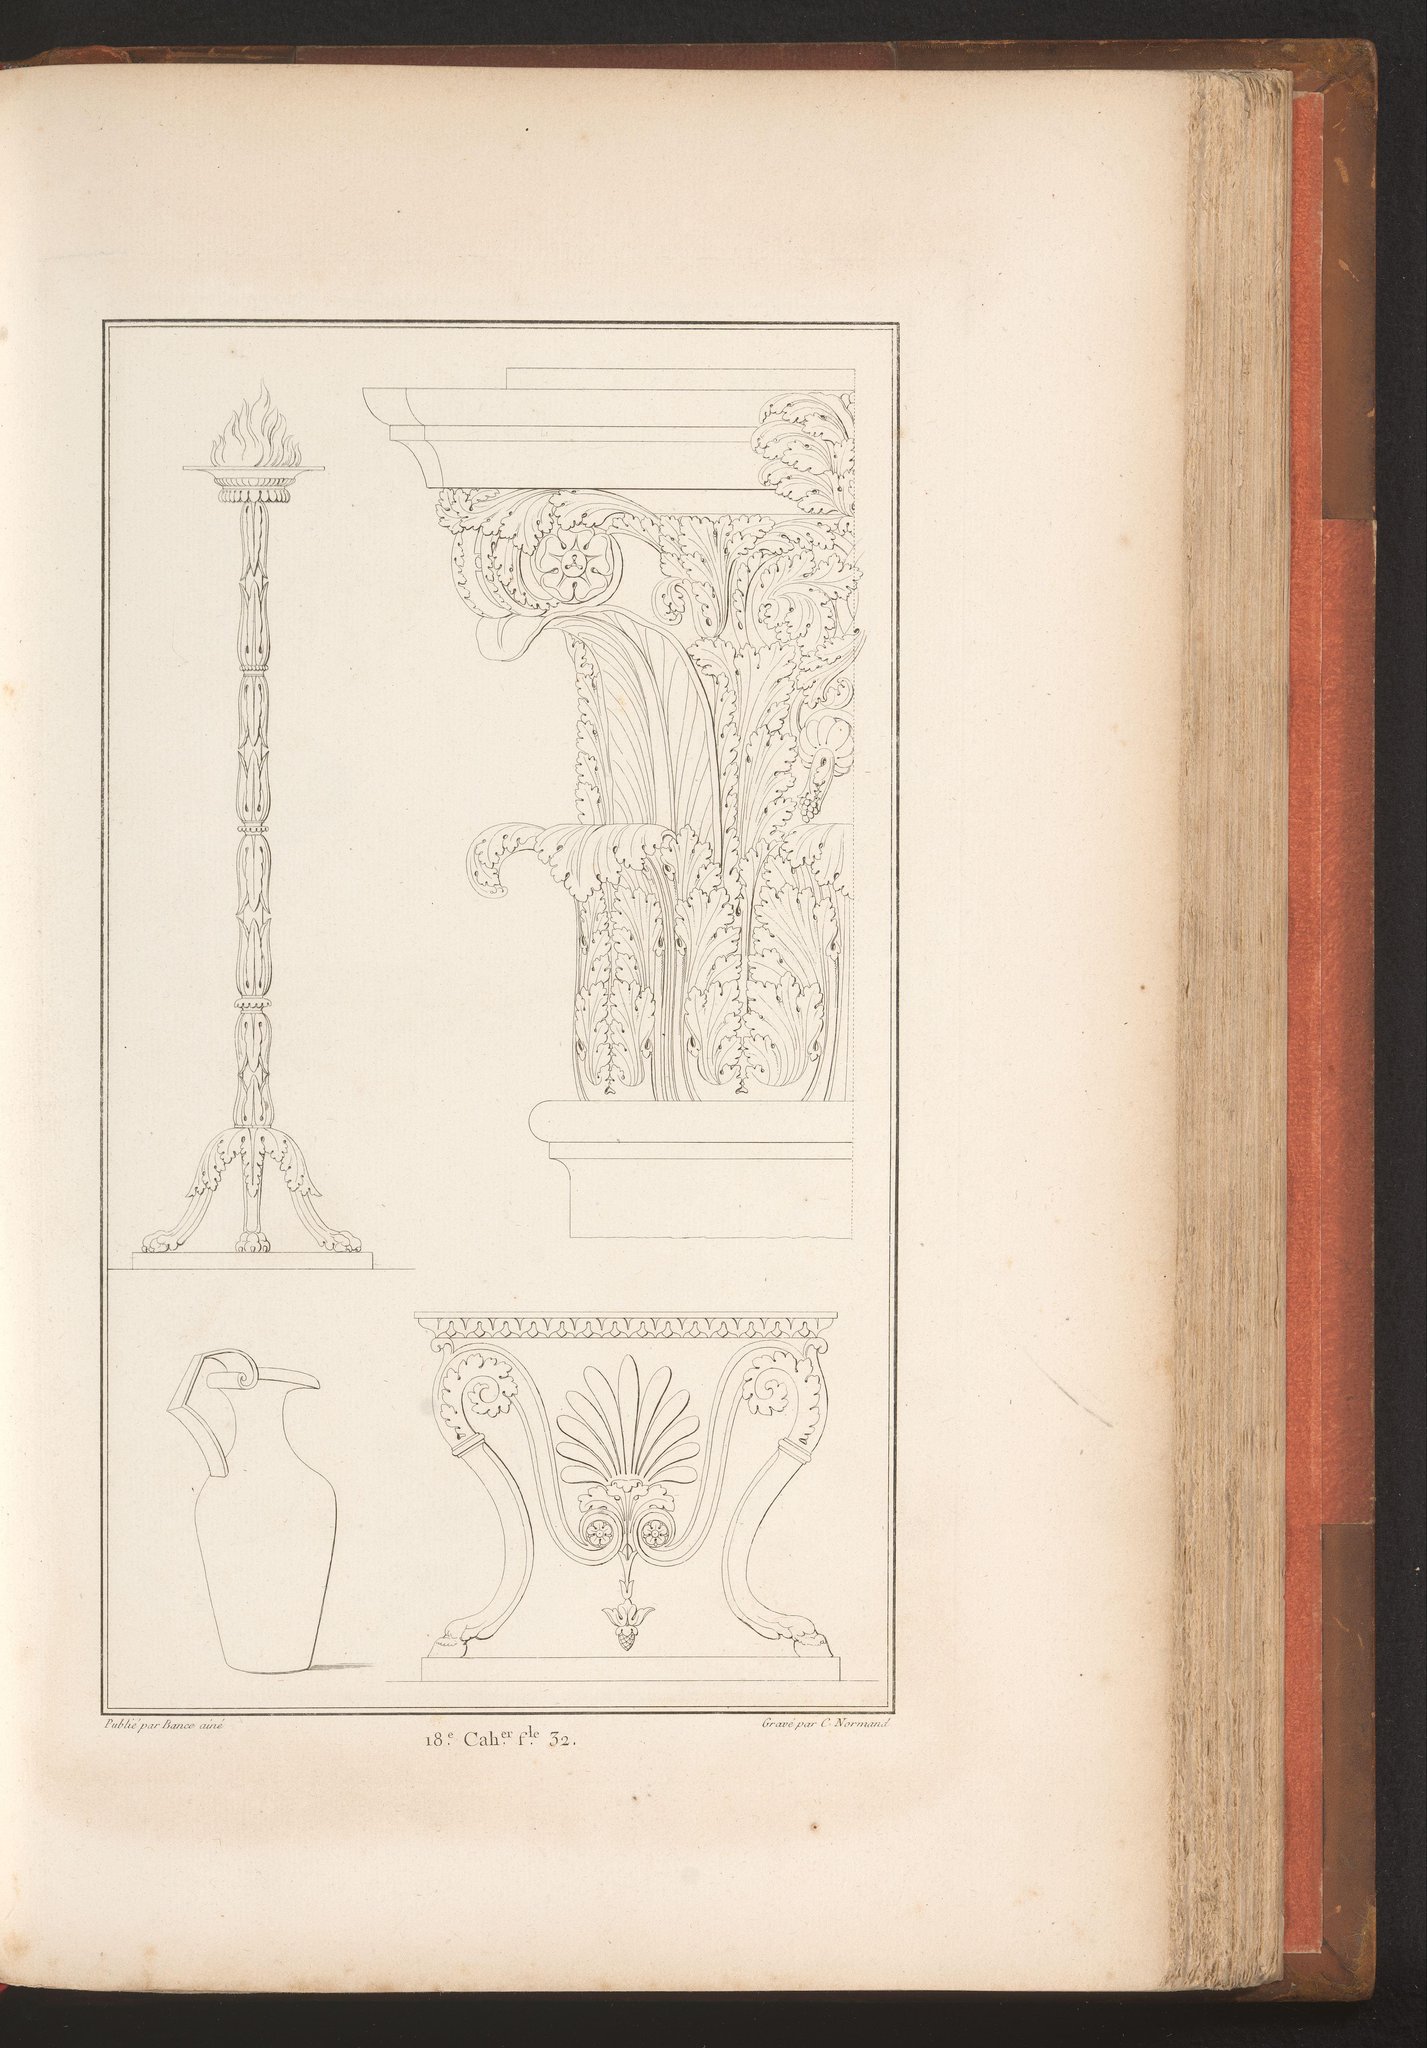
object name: ornament print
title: Kapiteel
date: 1820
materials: paper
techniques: etching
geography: paris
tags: ornaments ~ art, capital (~ column, pillar)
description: Ornamentprent met een kapiteel en andere objecten. Onderdeel (18e. Cah.er f.le 32) van het prentalbum met twee series van in totaal 138 ornamentprenten door Beauvallet en Normand, 'Fragmens d'Ornemens dans le Style Antique'.